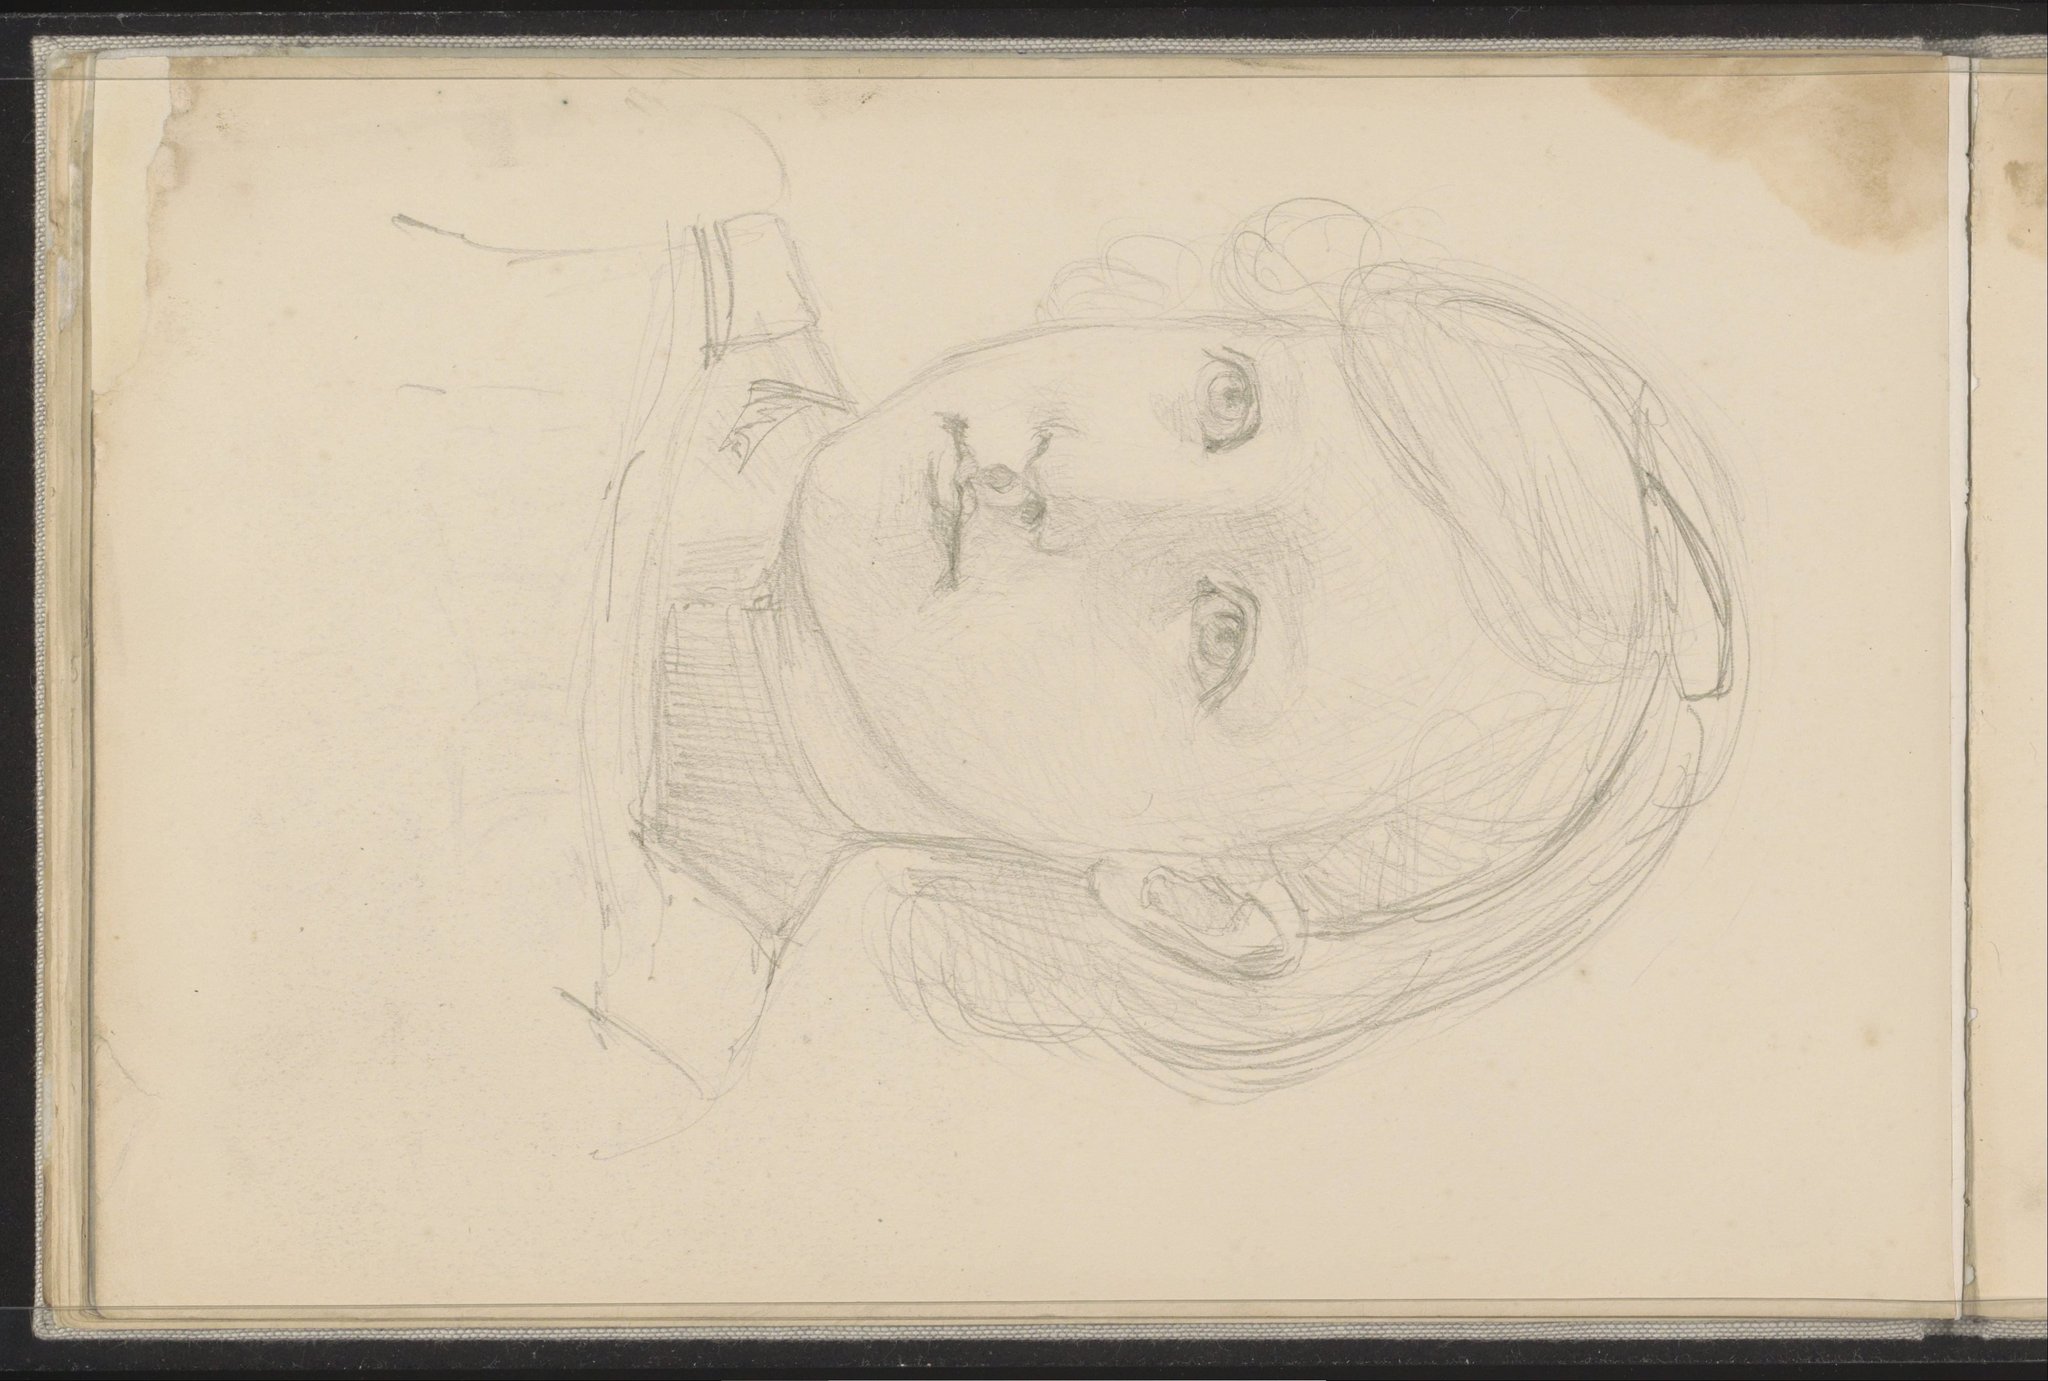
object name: sketchbook leaf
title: Meisjeskop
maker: jozef israëls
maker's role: draughtsman, painter, print maker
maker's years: 1824-1911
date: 1834-1911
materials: paper, pencil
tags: head (human), girl (child between toddler and youth)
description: Blad 20 verso uit een schetsboek met 30 bladen.